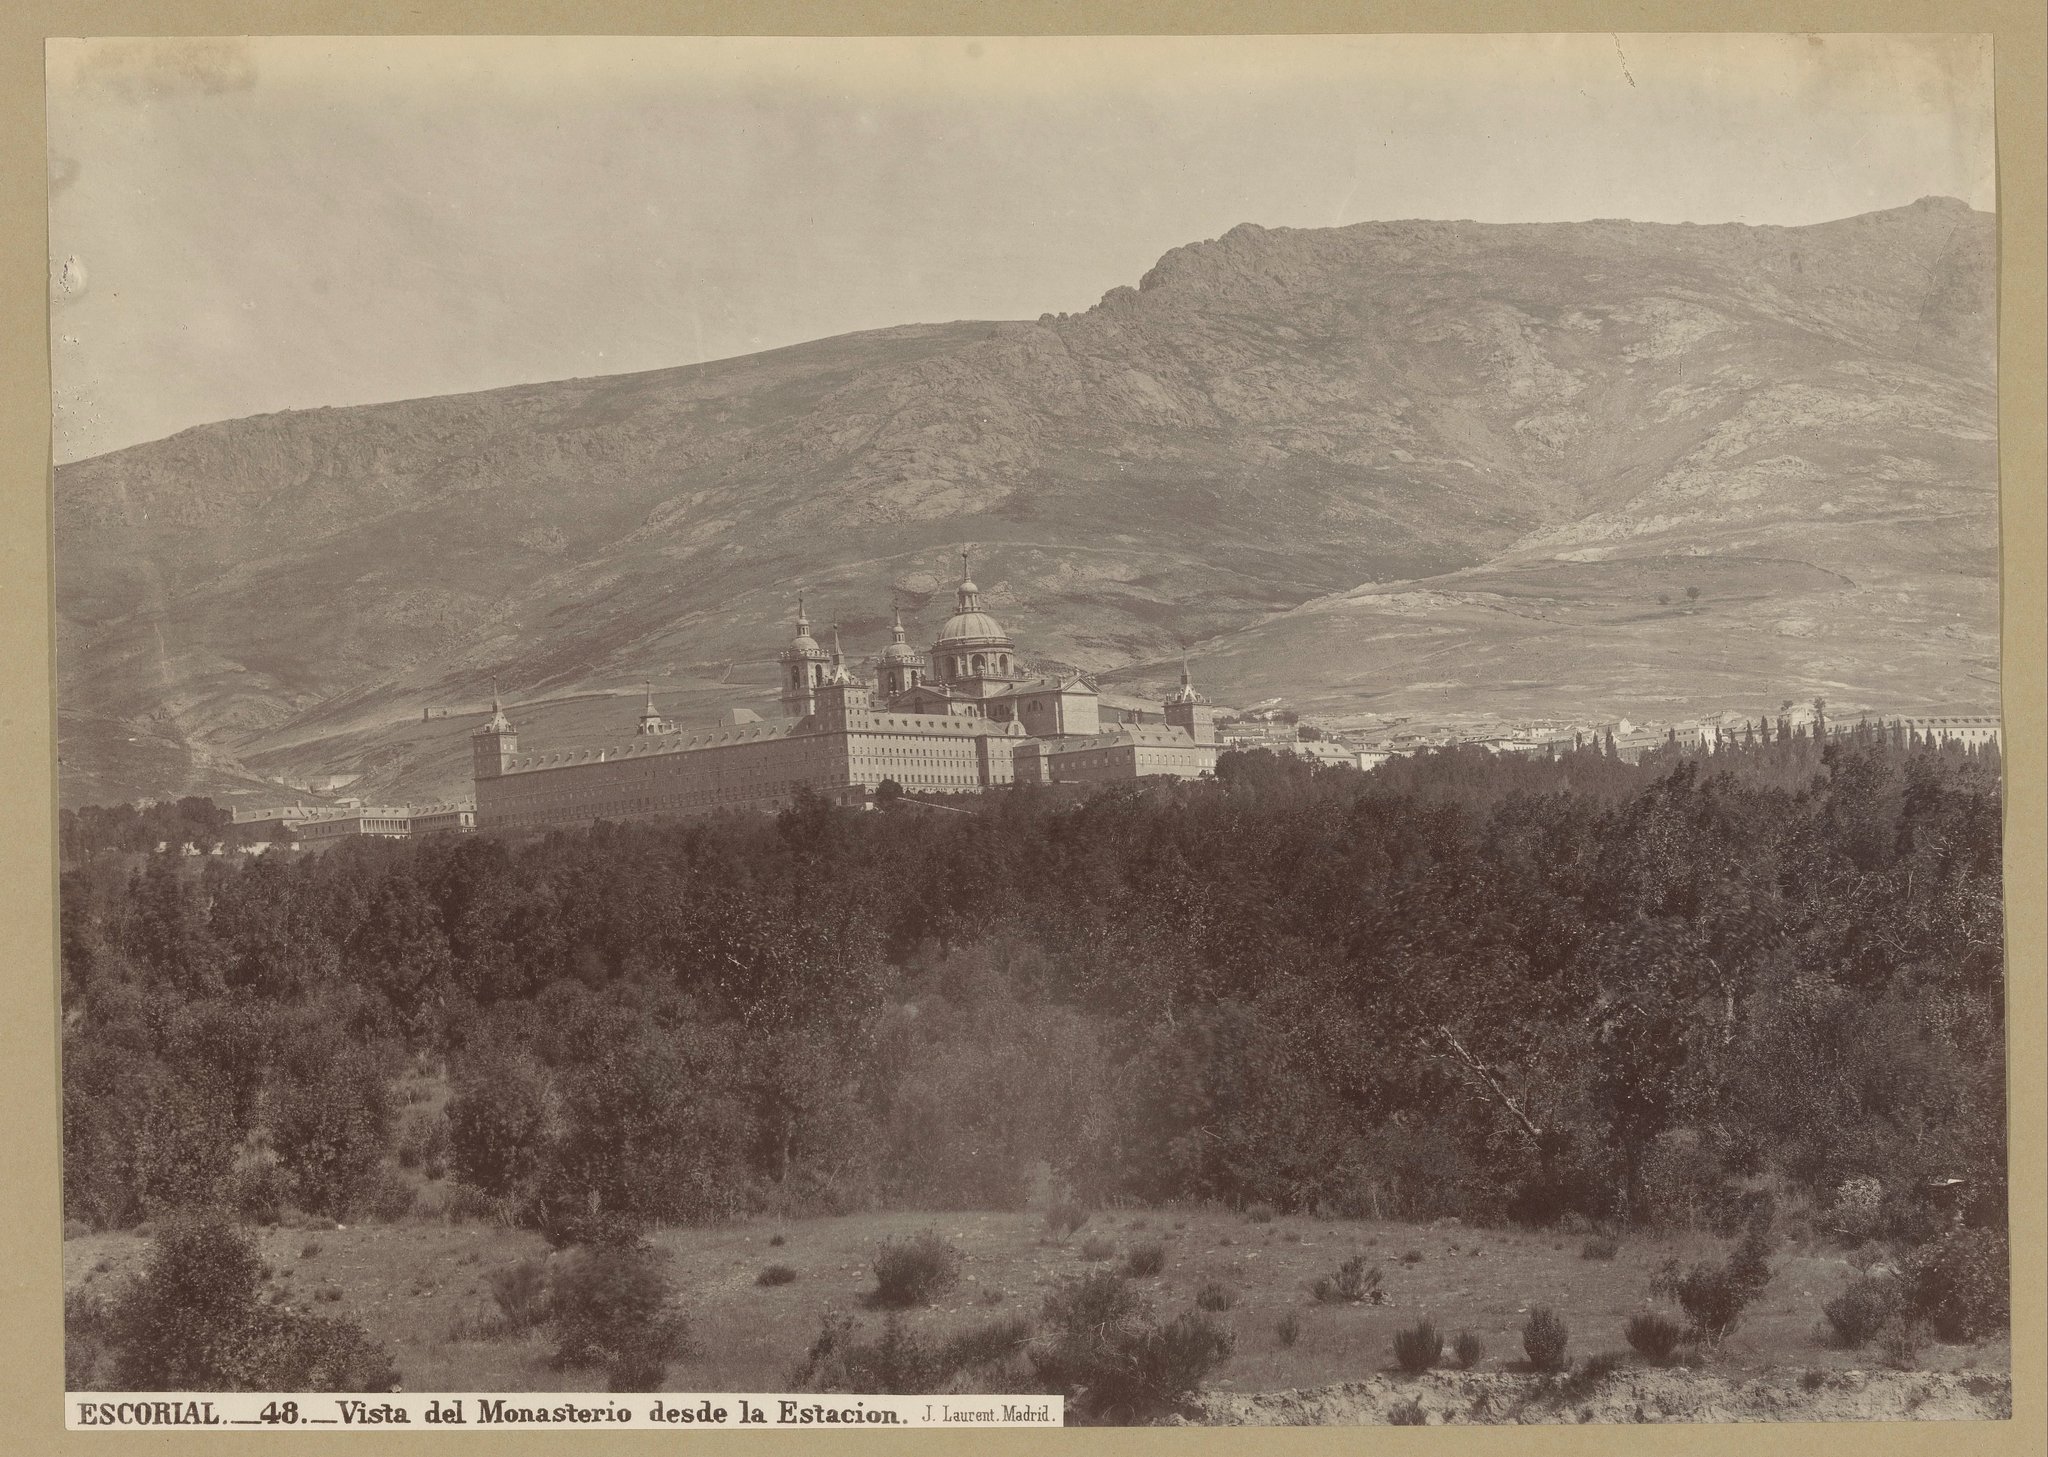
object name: album leaf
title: Gezicht op het Escorial nabij San Lorenzo de El Escorial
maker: juan laurent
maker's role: publisher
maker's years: 1816-1896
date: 1856-1863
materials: paper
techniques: albumen print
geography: san lorenzo de el escorial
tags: abbey, monastery, convent ~ roman catholic church, palace, mausoleum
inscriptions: number: ‘48.’